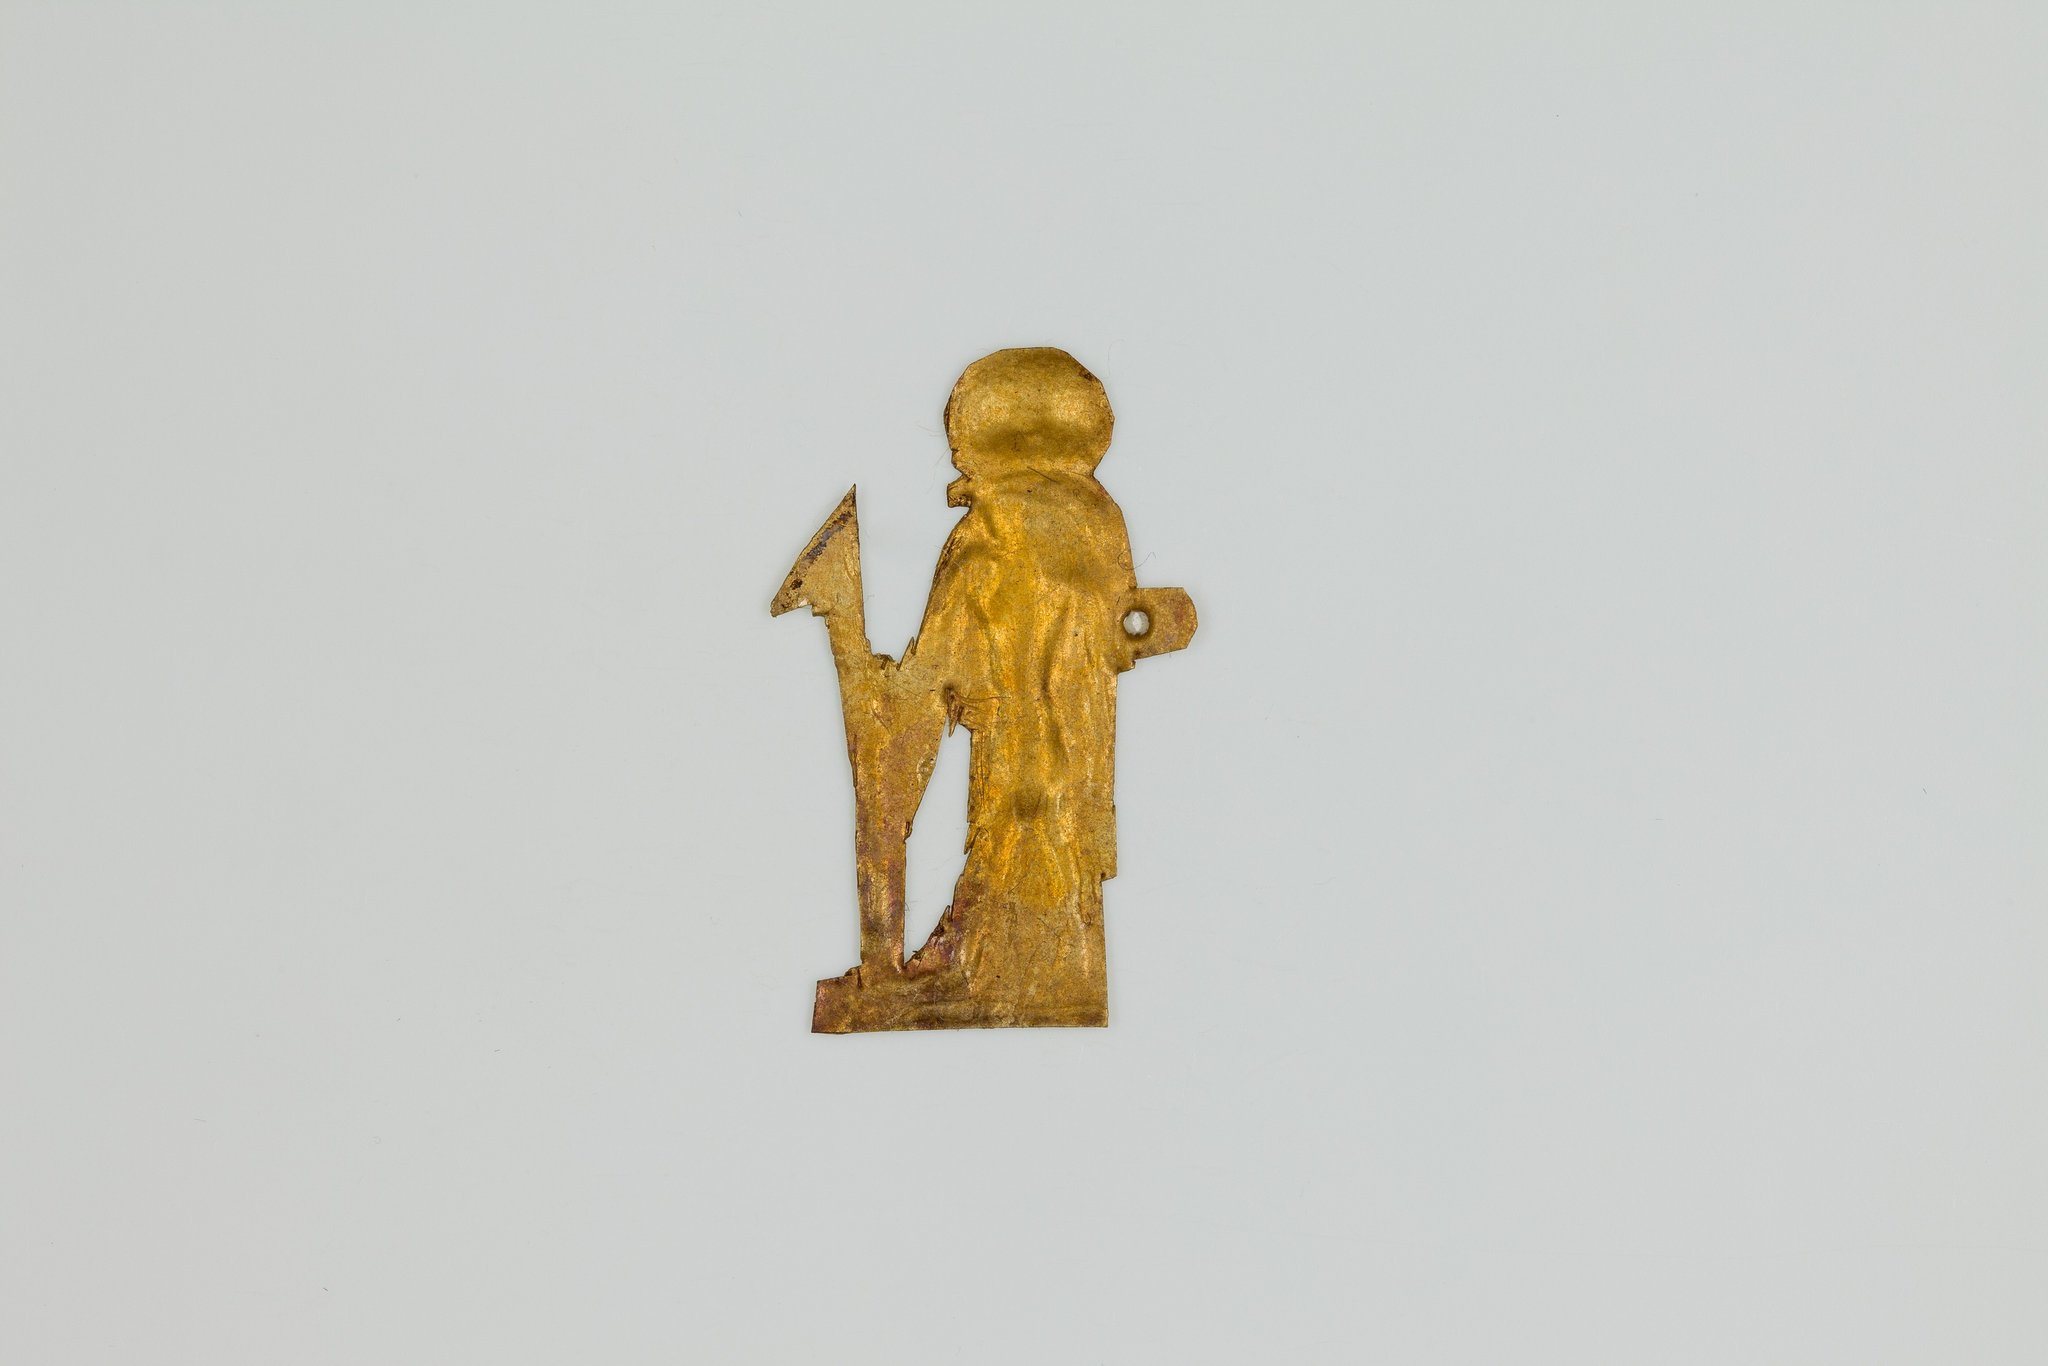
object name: amulet, re harakhty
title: Re-Harakhty amulet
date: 664-380 BCE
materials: gold